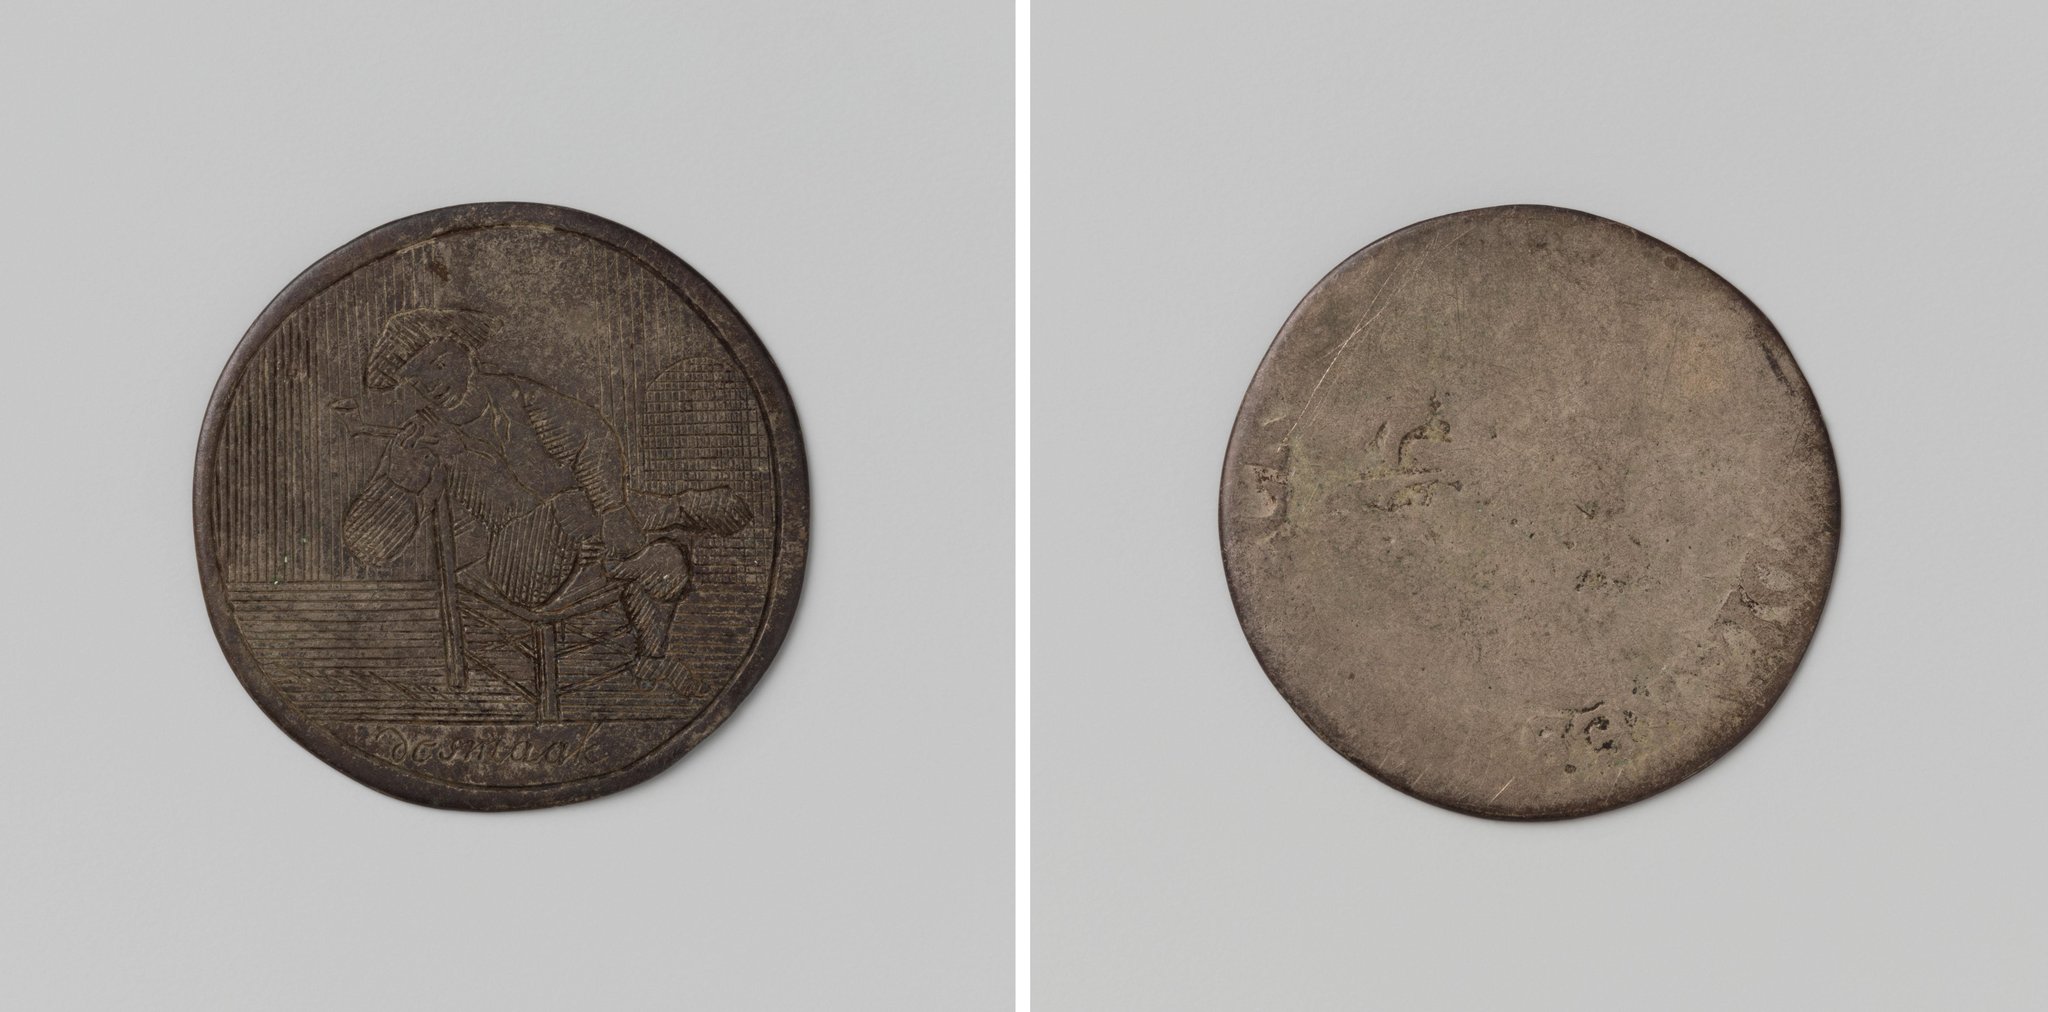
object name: stoter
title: De smaak, voorstelling gegraveerd op een Leicester-stoter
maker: Anonymous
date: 1586-1597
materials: silver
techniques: engraving, striking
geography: netherlands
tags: william i (prince of orange), robert dudley (1st earl of leicester)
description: Zilveren penning. Voorzijde: naar rechts gewende met hoed zit met over elkaar geslagen benen pijp te roken; afsnede: opschrift. Keerzijde: oorspronkelijke voorstelling: naar links gewend borststuk man met lauwerkrans binnen omschrift. Mogelijk een stoter.